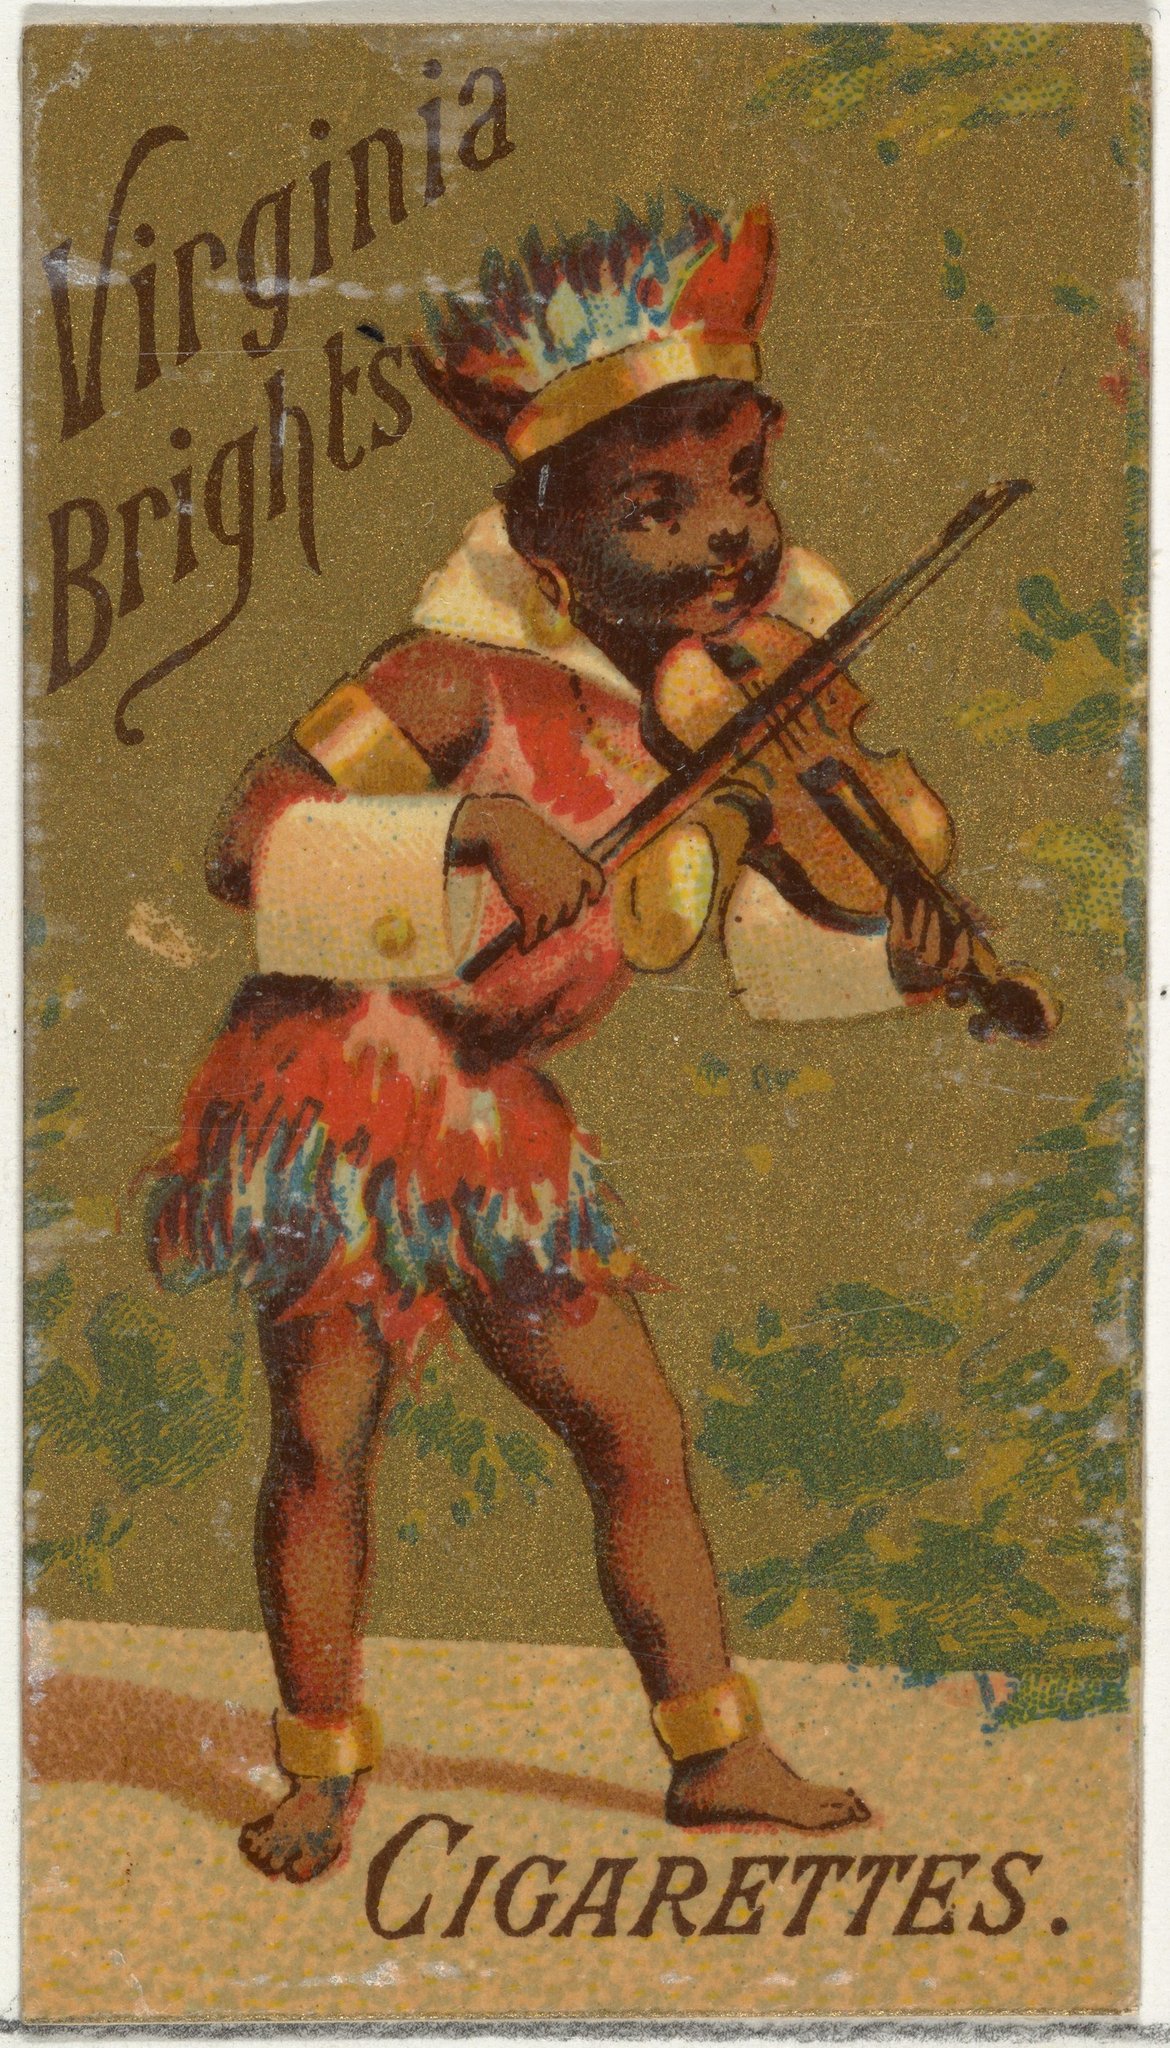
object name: print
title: Caricatured Figure (Fiddler) from Girls and Children series (N64) promoting Virginia Brights Cigarettes for Allen & Ginter brand tobacco products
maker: allen & ginter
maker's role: publisher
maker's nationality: american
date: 1886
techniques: color lithograph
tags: children,music,violins